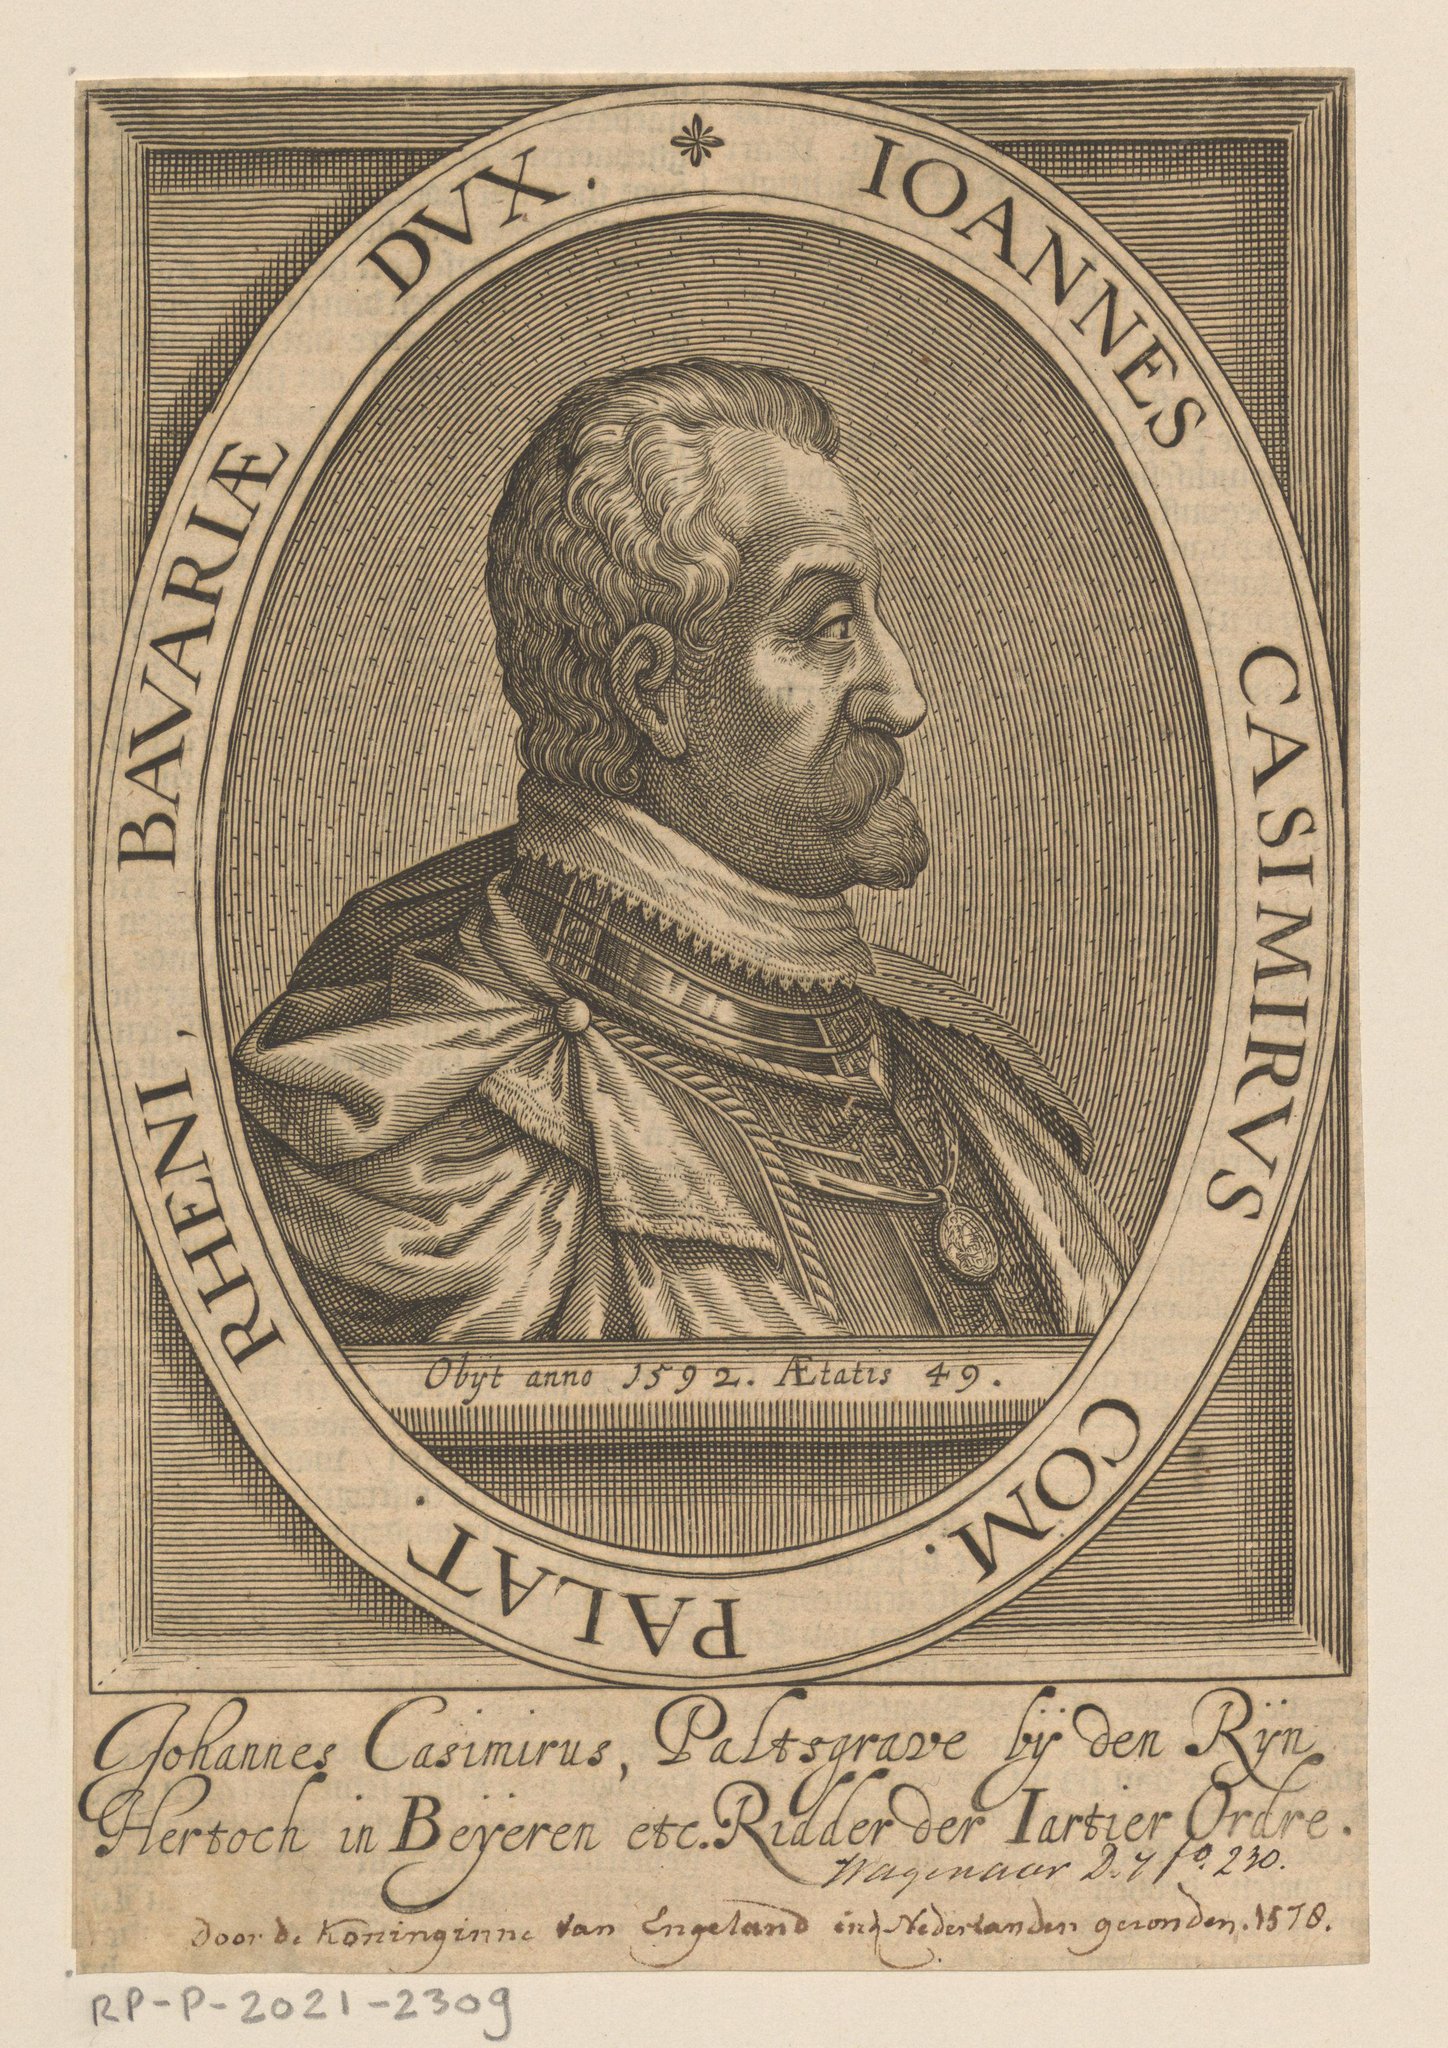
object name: print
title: Portret van Johan Casimir van Palts-Lautern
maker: Anonymous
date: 1617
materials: paper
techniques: engraving, letterpress printing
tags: historical persons, ruler, sovereign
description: Prent met andere tekst op verso gebruikt in: Tooneel der beroemder hertogen princen graven ende krygs-helden van christenrijck binnen deze drij laetste eeuwen. Delft: Nicolaes de Clerck, 1617, p. 226.